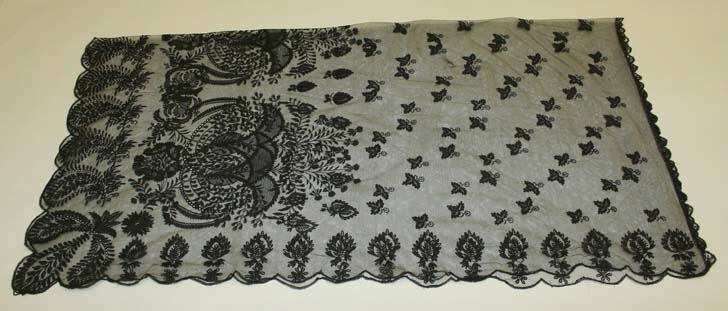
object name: veil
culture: american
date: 1801-1833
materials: silk